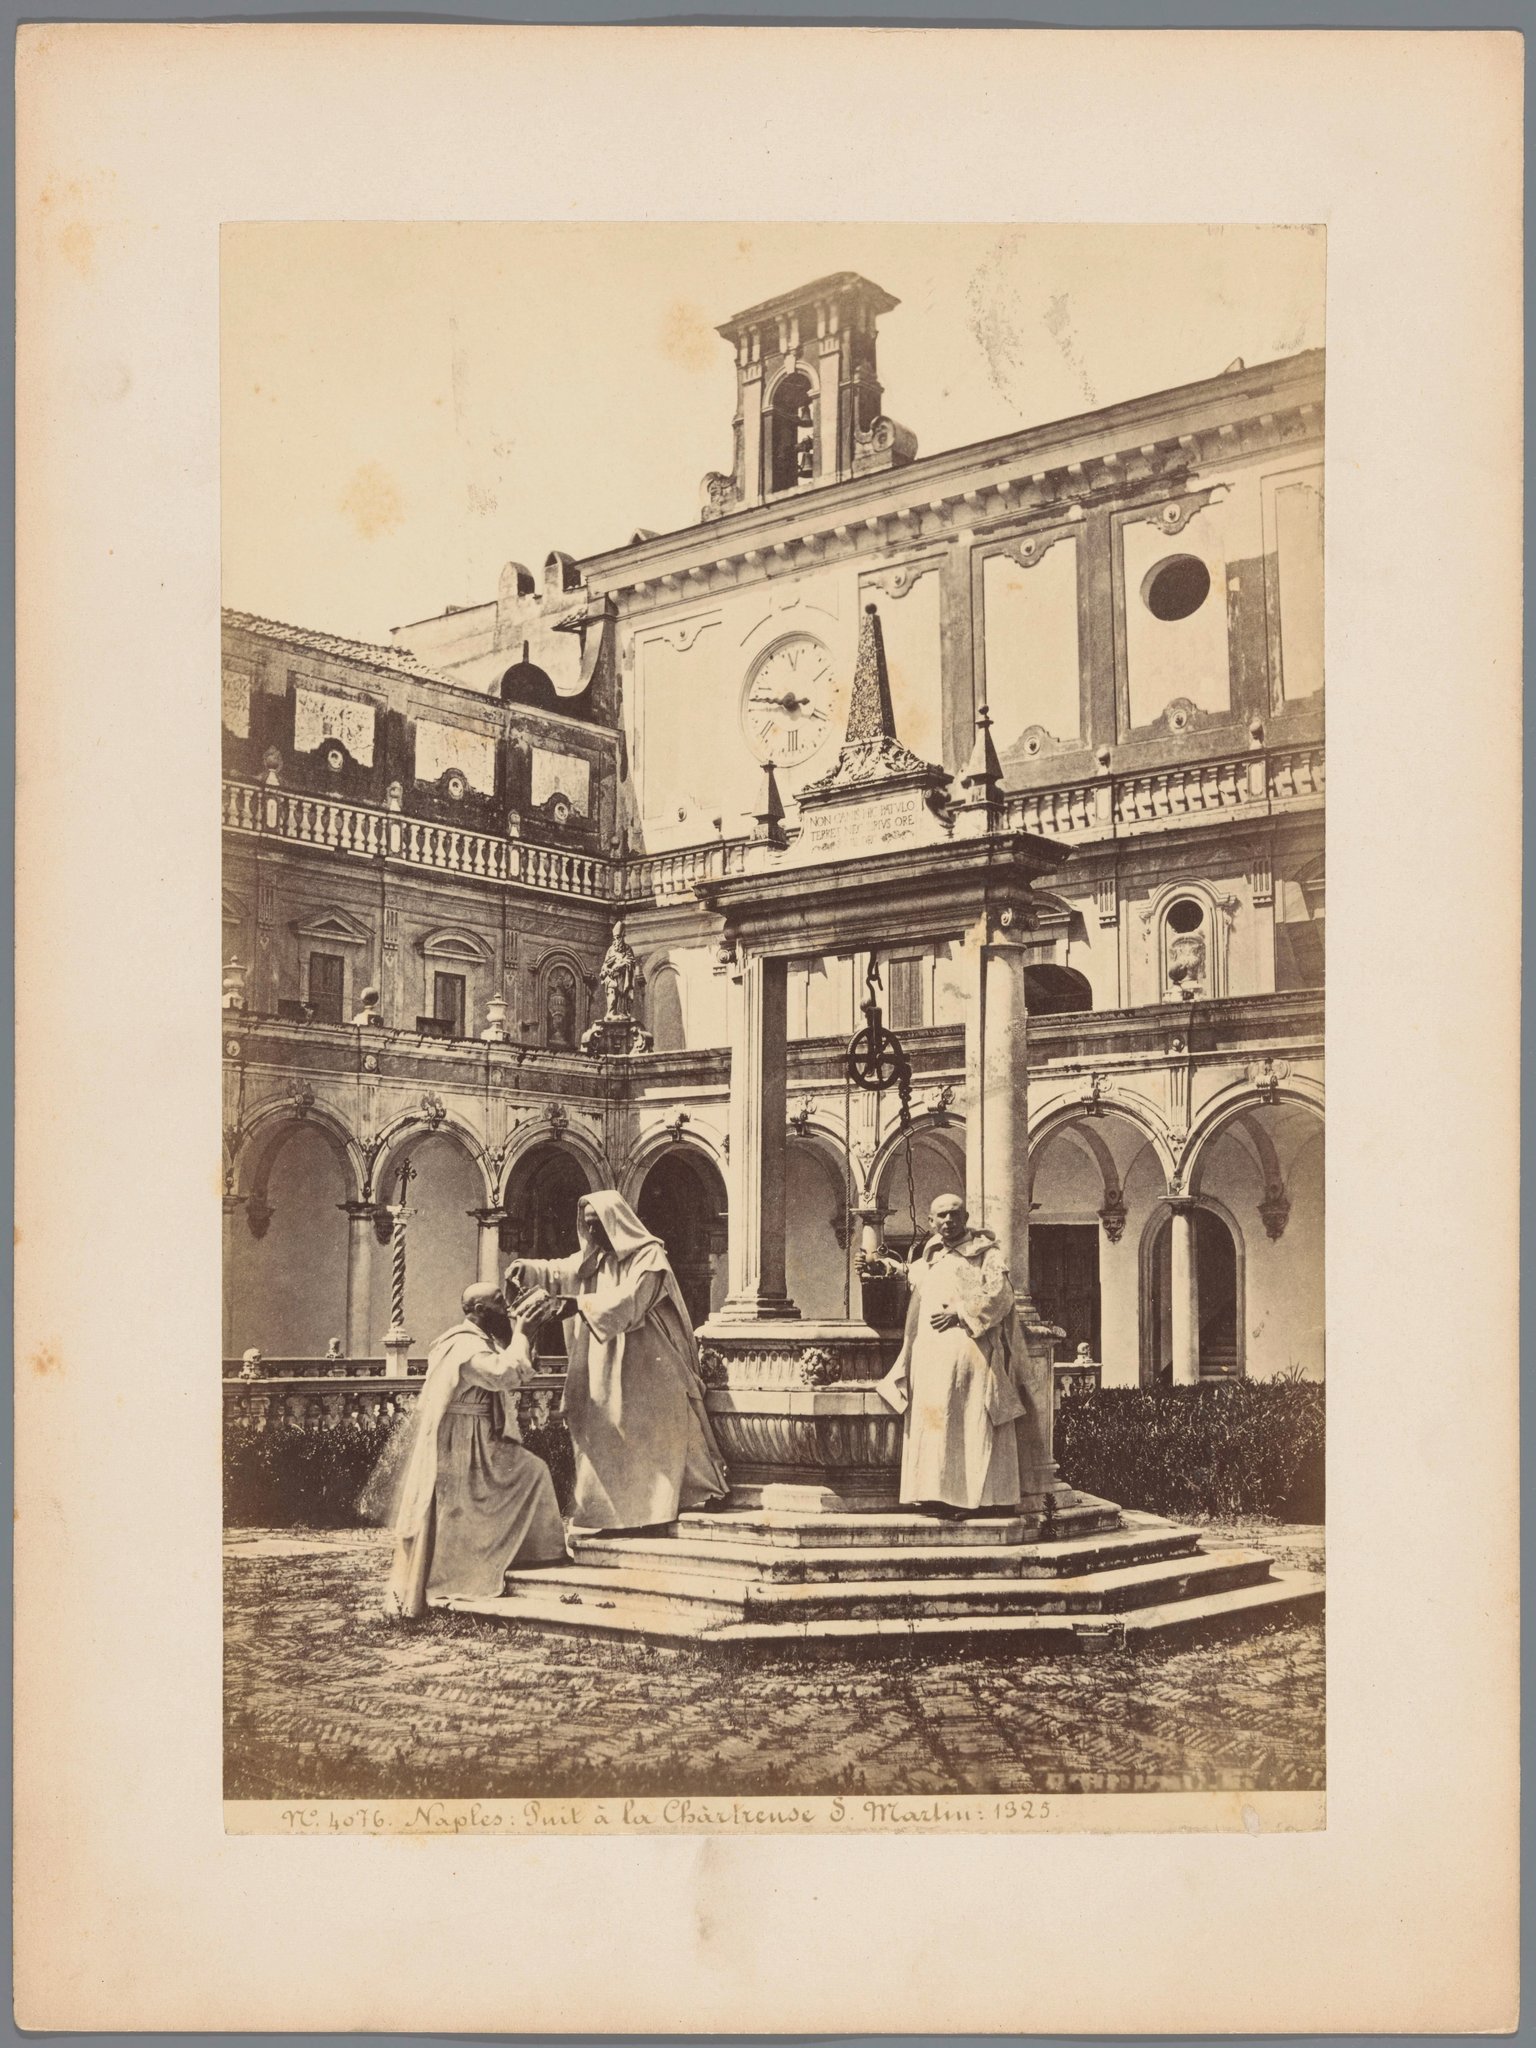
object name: photograph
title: Waterput in het kartuizerklooster van San Martino te Napels, met op de voorgrond drinkende monniken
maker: Anonymous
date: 1875-1900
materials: cardboard, photographic support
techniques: albumen print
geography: certosa di san martino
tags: well, monk(s), friar(s), cloisters ~ monastery, exterior ~ representation of a building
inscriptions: collector's mark: Lugt 3937, number: ‘No. 4076.’